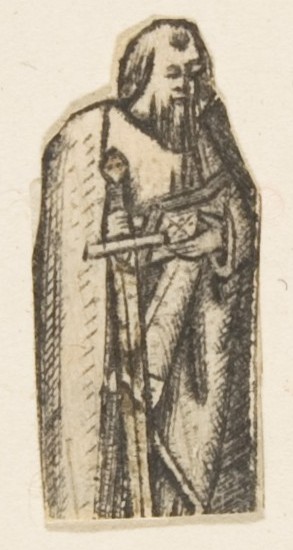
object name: print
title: Bearded Saint with a Sword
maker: anonymous, german, 15th century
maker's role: artist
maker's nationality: german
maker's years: 1400-1500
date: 1401-1500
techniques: woodcut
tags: swords,men,saints